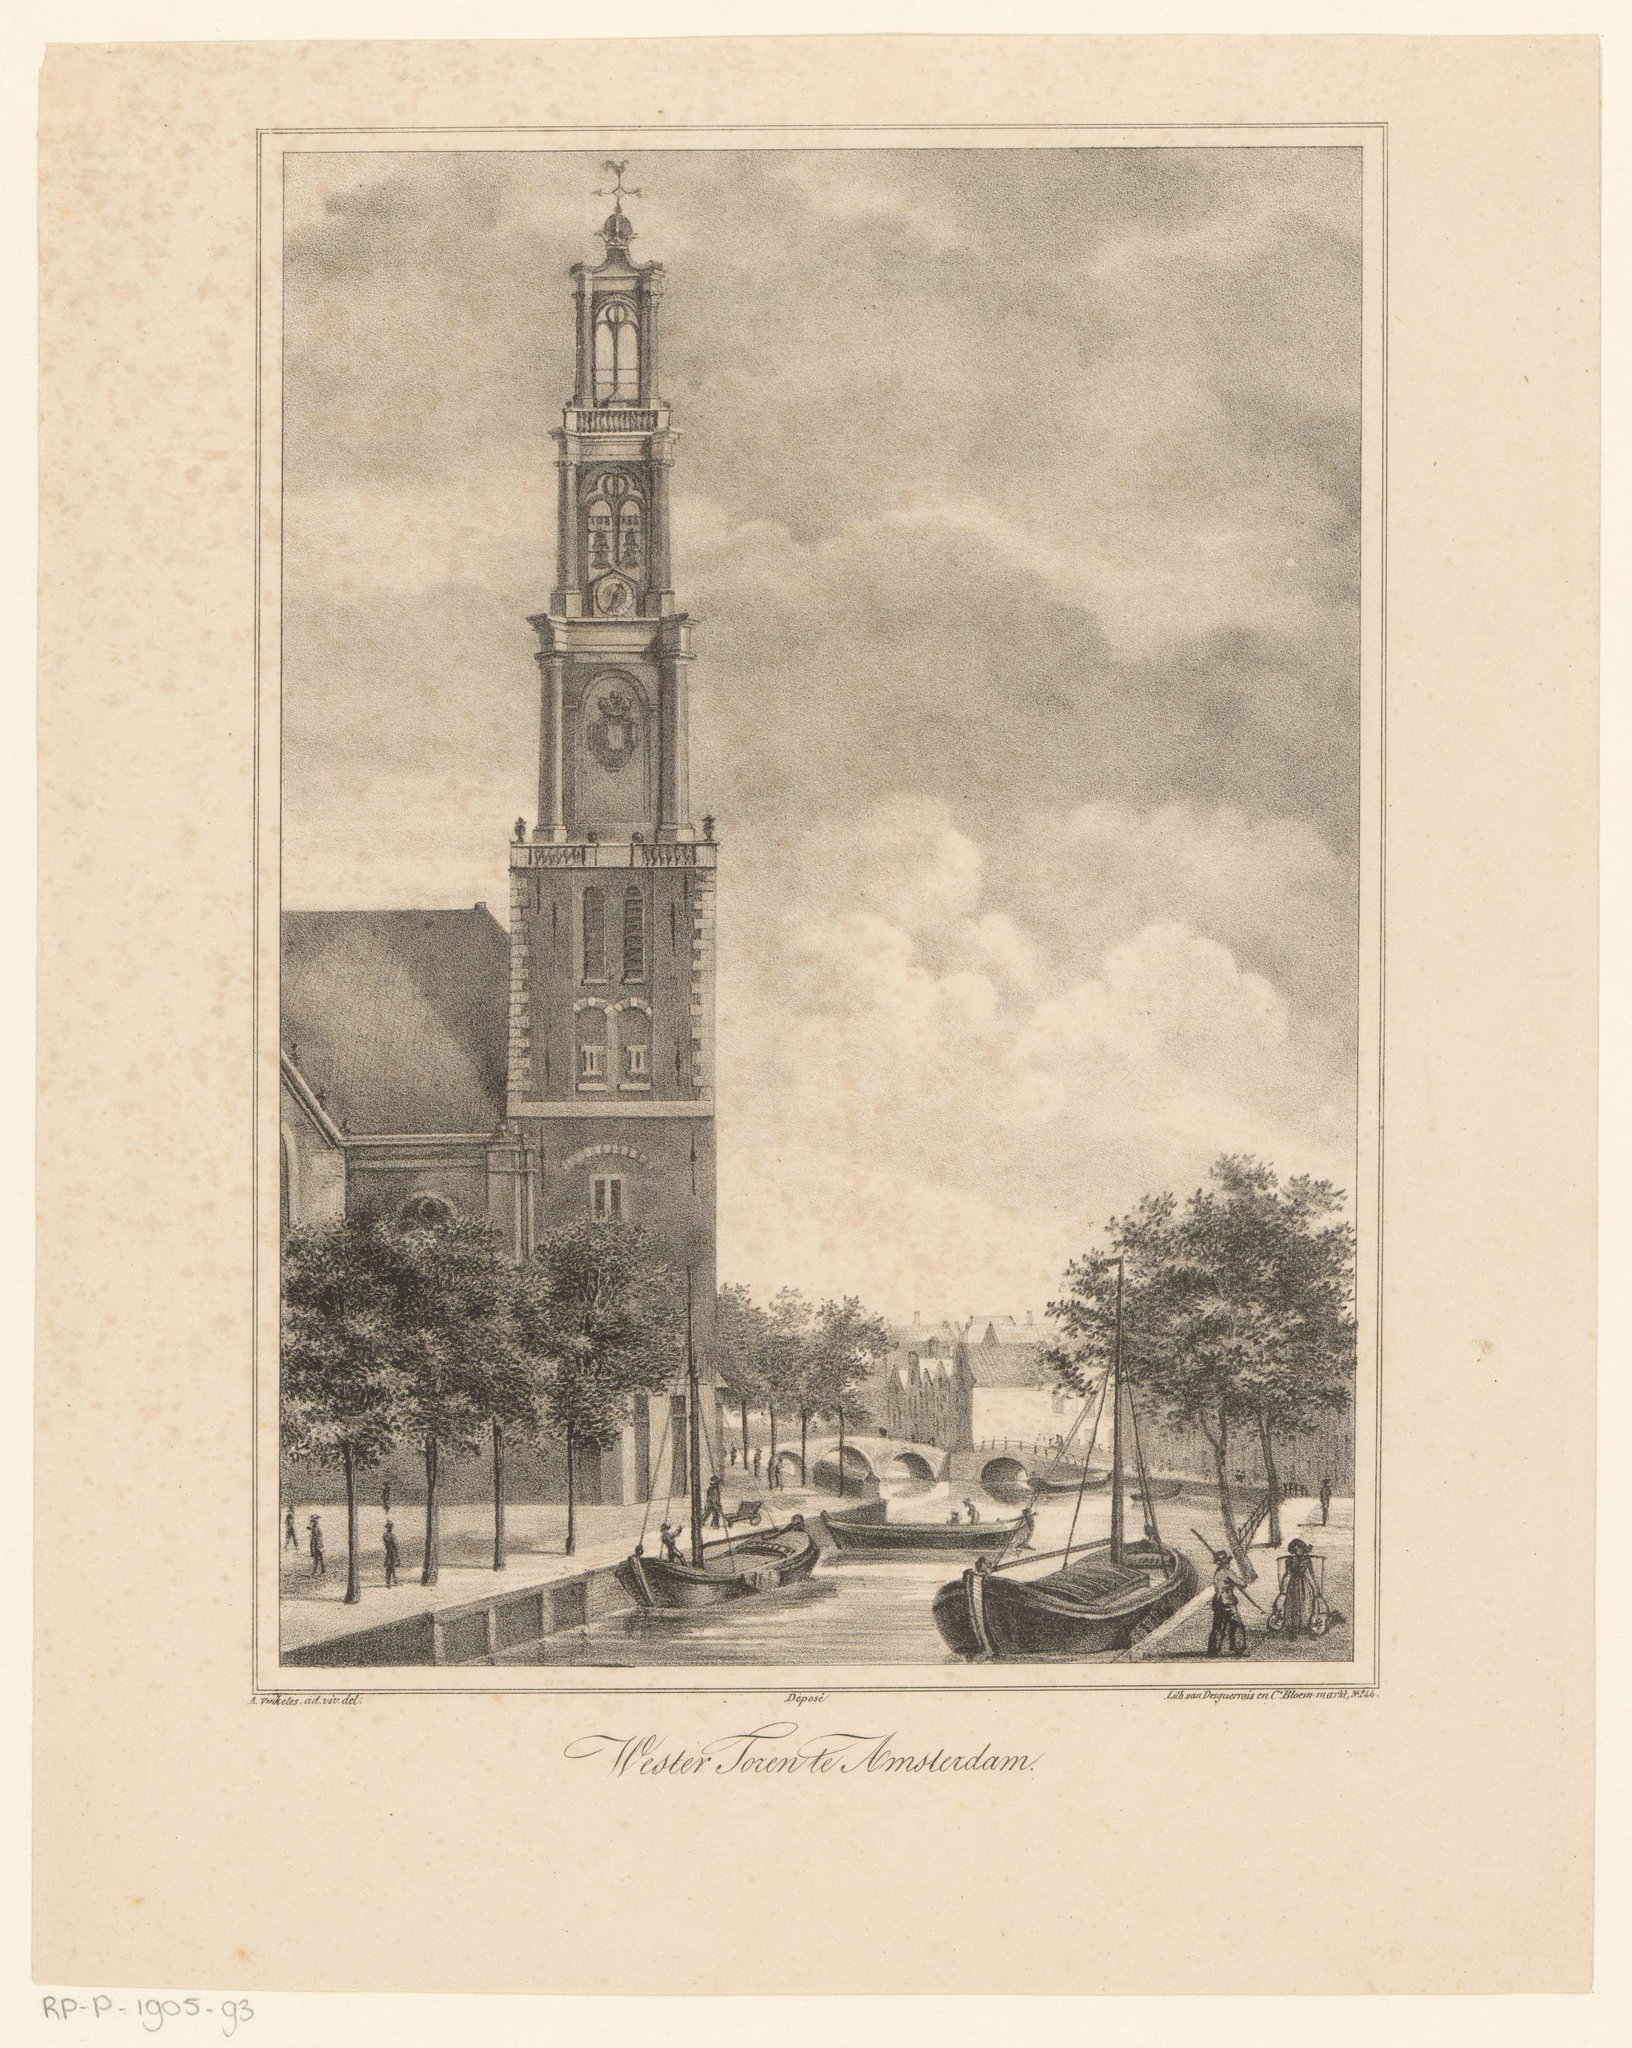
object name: print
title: Wester Toren te Amsterdam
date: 1828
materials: paper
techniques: lithograph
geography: amsterdam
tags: tower, clock tower ~ monumental adornment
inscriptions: : ‘Déposé.’, collector's mark: Lugt 2228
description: Prent is onderdeel van een serie van zes.